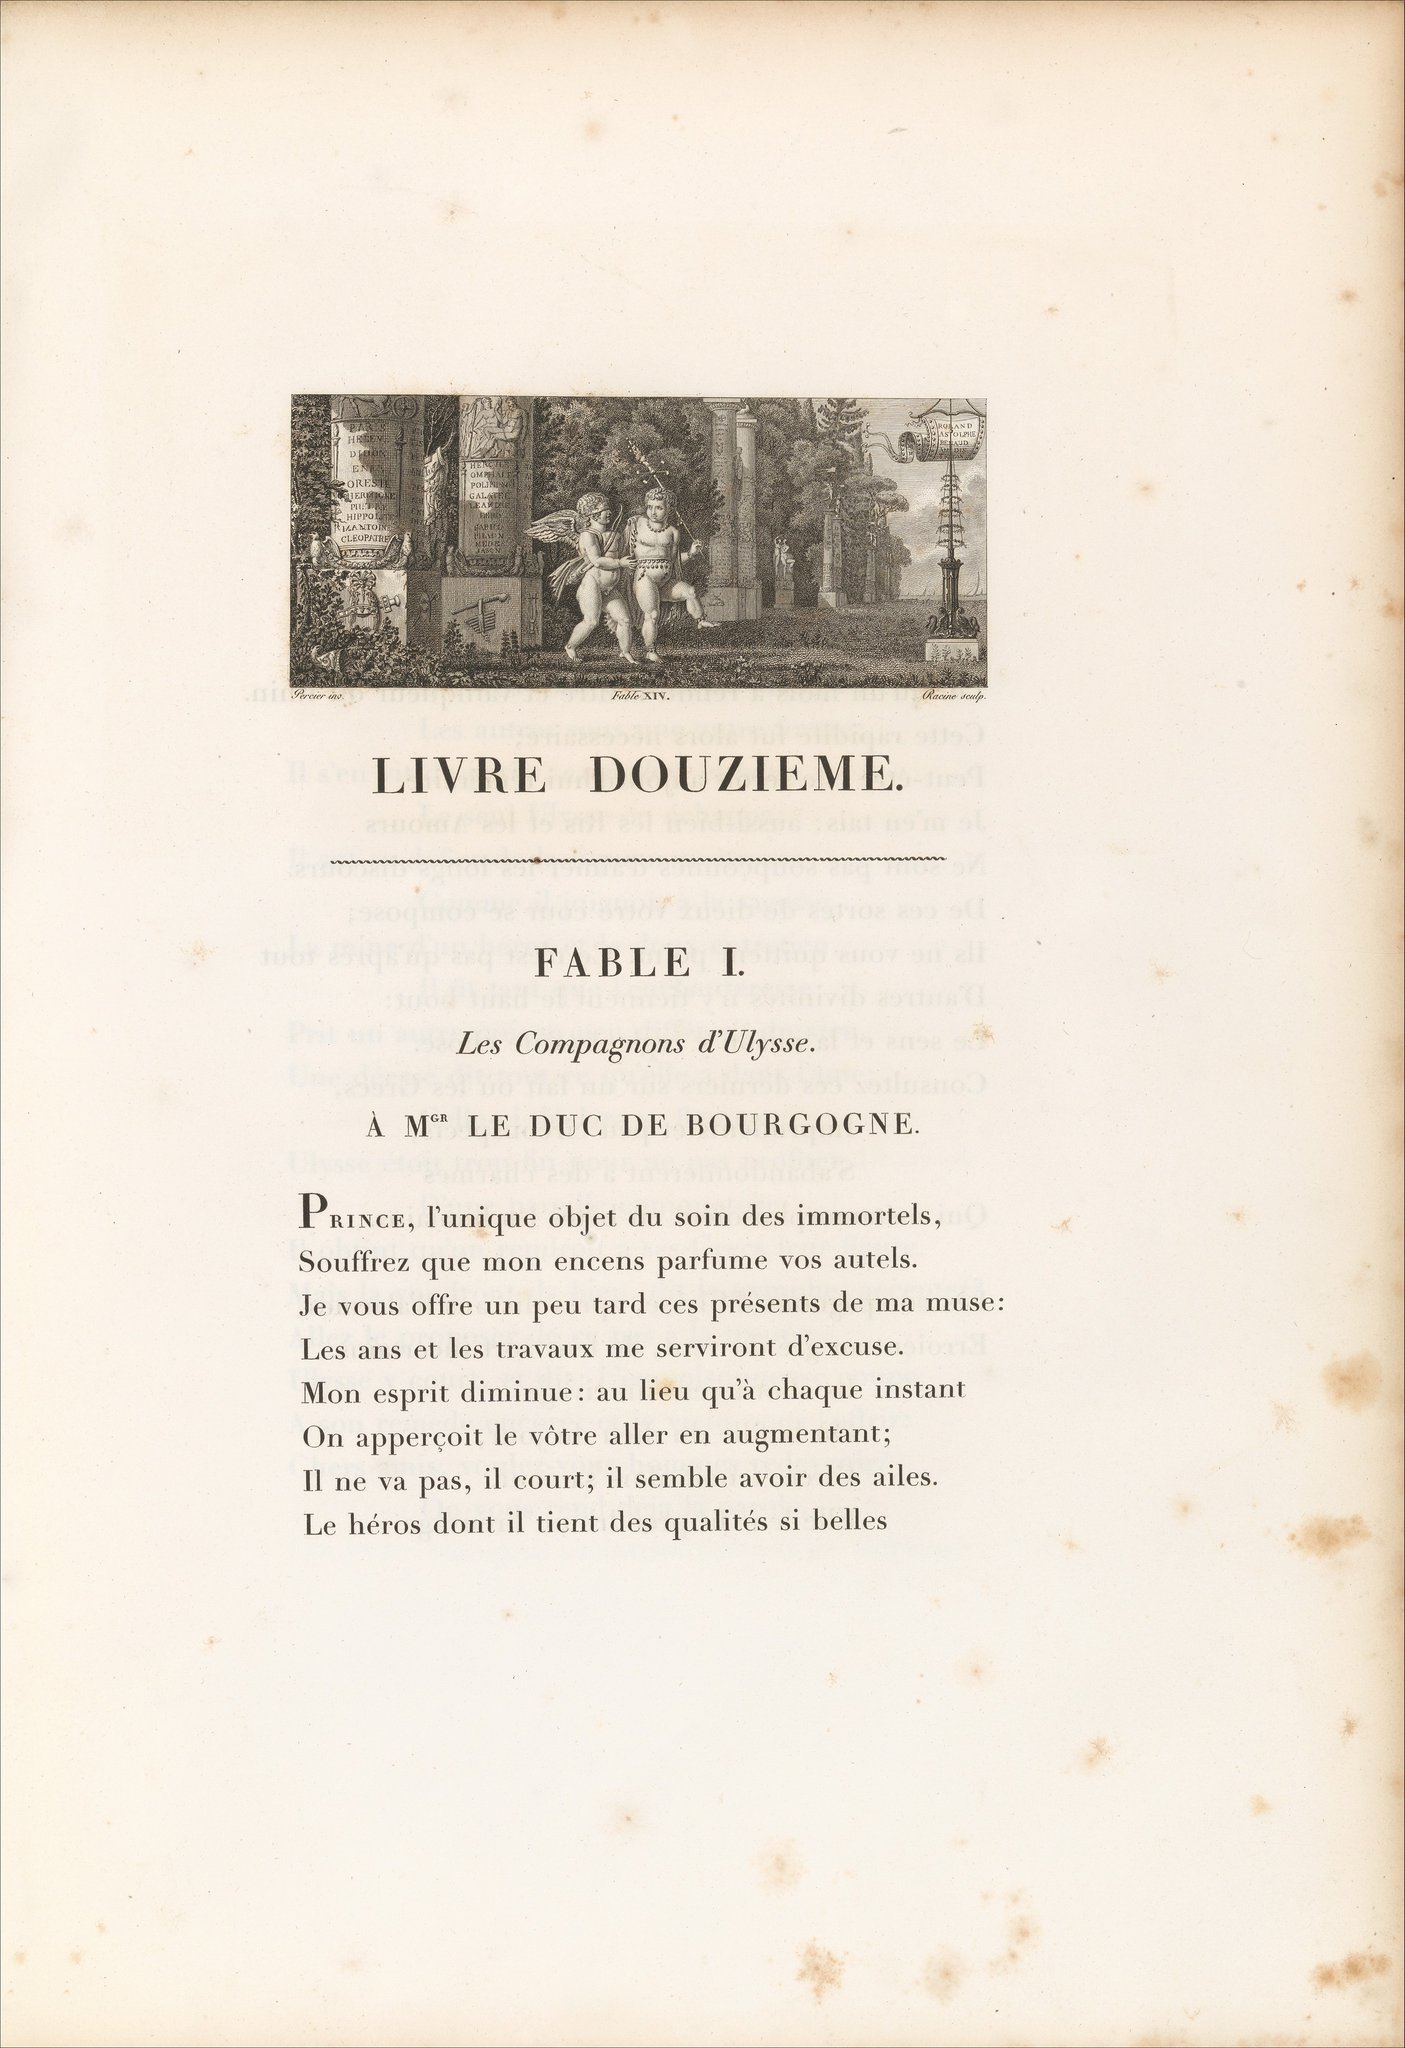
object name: book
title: Fables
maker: jean de la fontaine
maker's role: author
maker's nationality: french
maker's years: 1621-1695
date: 1802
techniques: engraving, printing